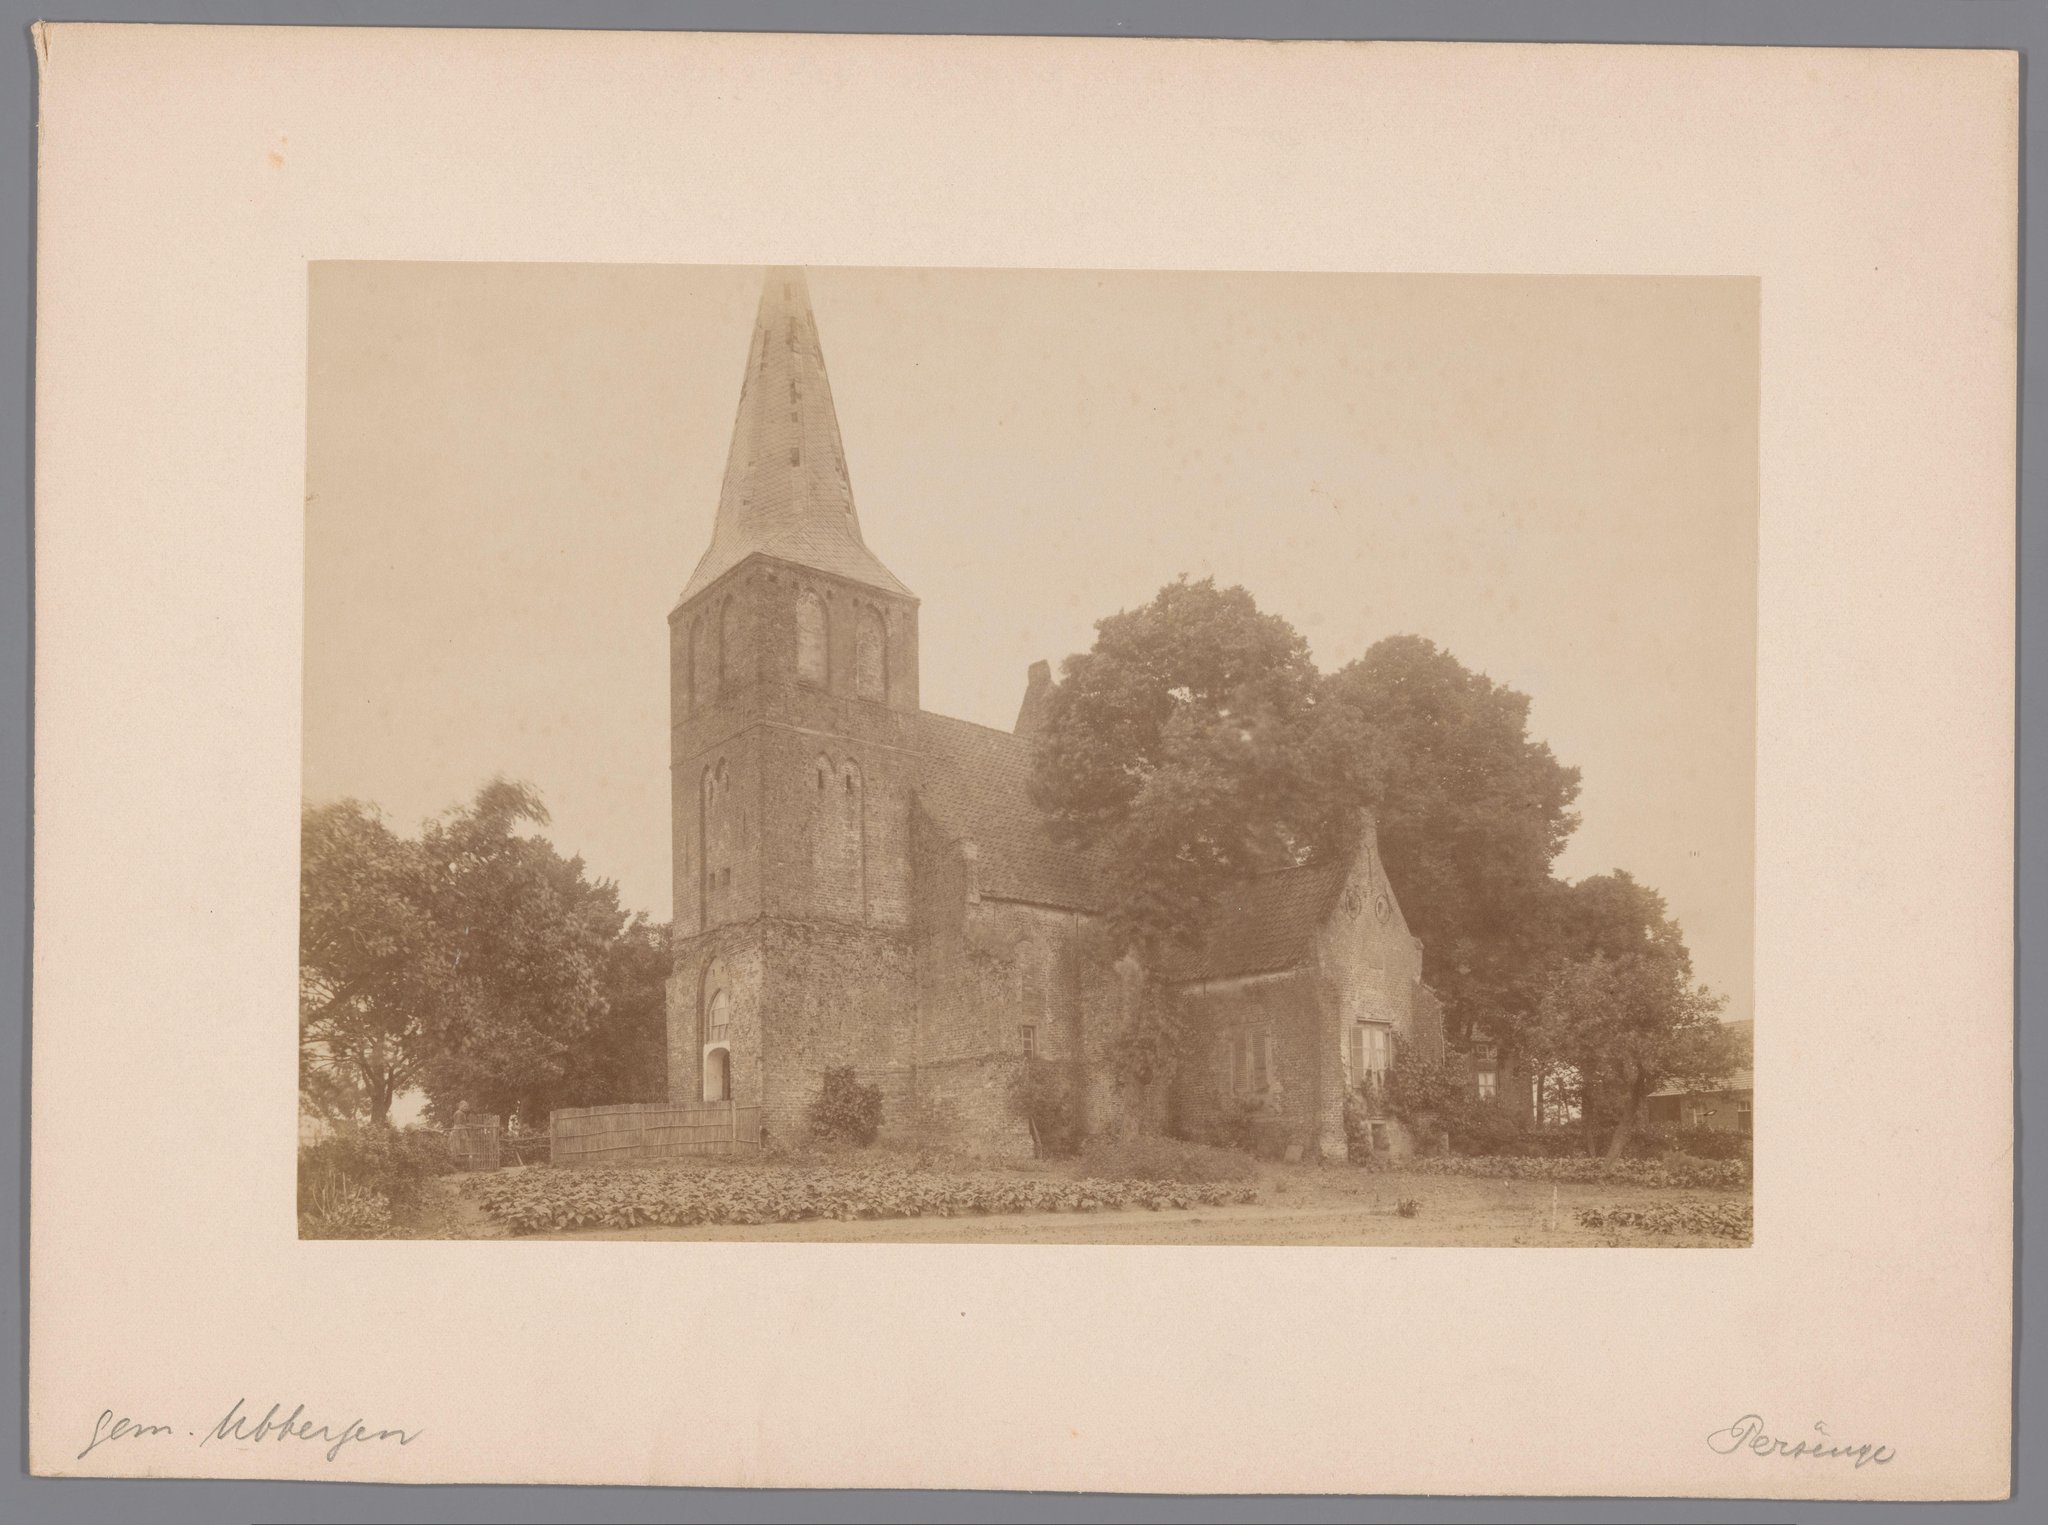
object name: photograph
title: Gezicht op de Hervormde Kerk te Persingen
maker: anoniem (monumentenzorg)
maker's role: fotograaf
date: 1899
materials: cardboard, photographic support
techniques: albumen print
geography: persingen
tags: church (exterior)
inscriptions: annotation: ‘gem. Ubbergen/ Persingen’, annotation: ‘Kerkje te Persinge bij Nijmegen (G.)/ Juni 1899’